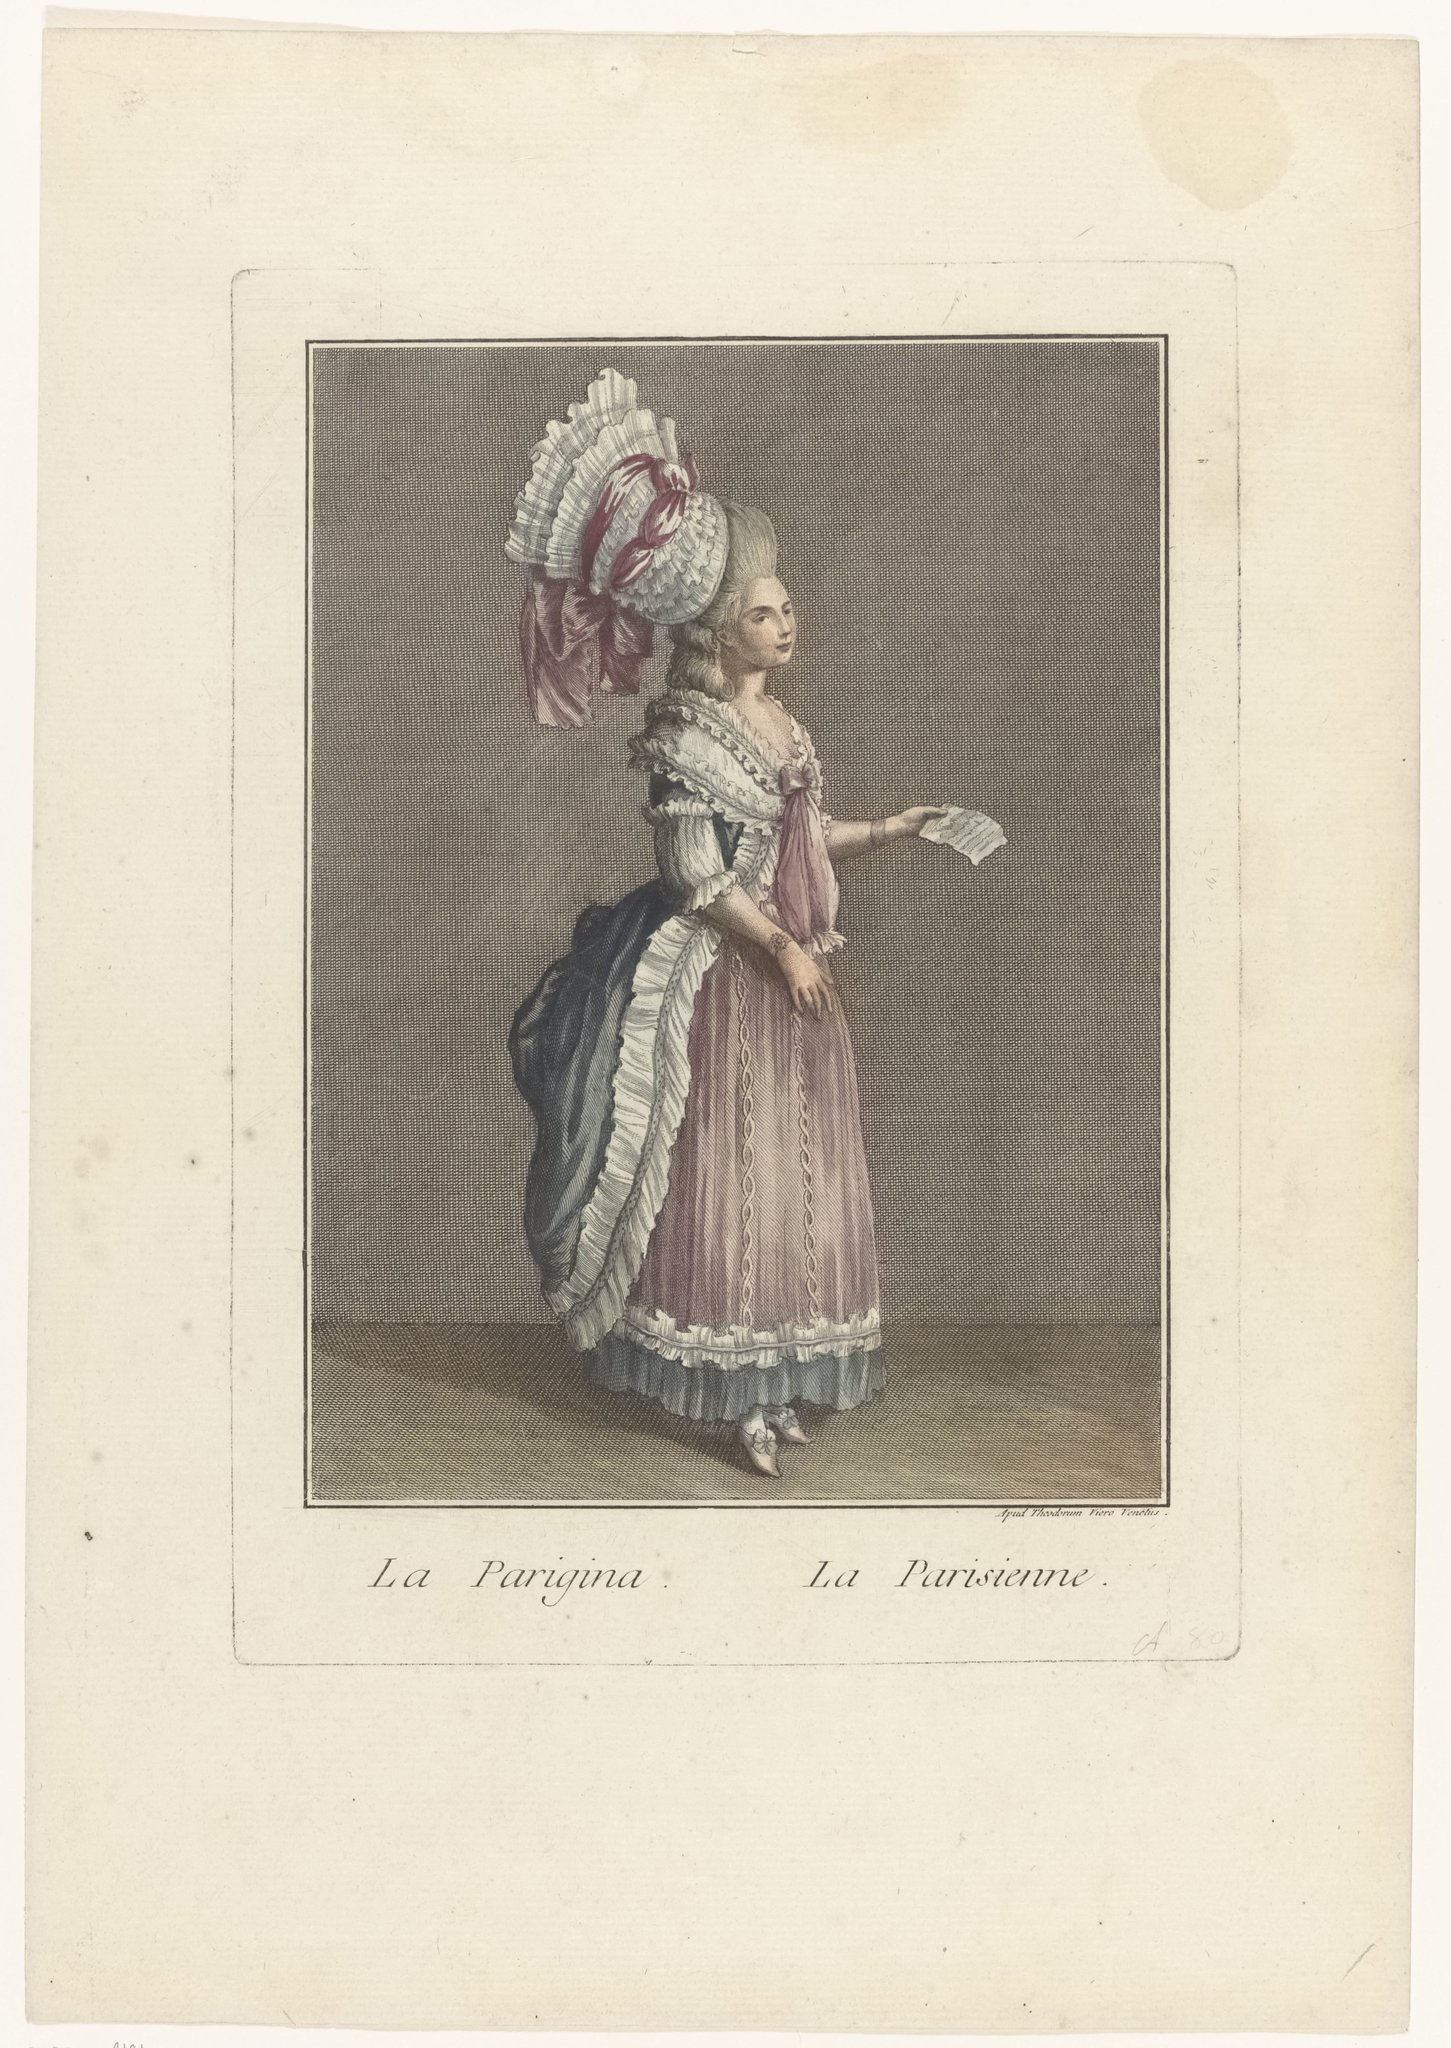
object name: fashion print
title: La Parigina / La Parisienne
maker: teodoro viero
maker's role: draughtsman, print maker, publisher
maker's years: 1740-1819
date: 1783-1791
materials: paper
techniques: engraving, hand coloring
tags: fashion plates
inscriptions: title: ‘La Parigina / La Parisienne’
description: Vrouw naar rechts, een briefje in de hand, gekleed volgens de mode van 1778. Ze is gekleed in een Robe à la Polonaise en heeft een hoge Engelse bonnet op het hoofd. Uit de serie Raccolta di ... stampe che rappresentano figure ed abiti die varie nazioni.... Venedig, 1783-1791. Kopie P 89 van Gallerie des Modes... (zie RP-P-1976-20)